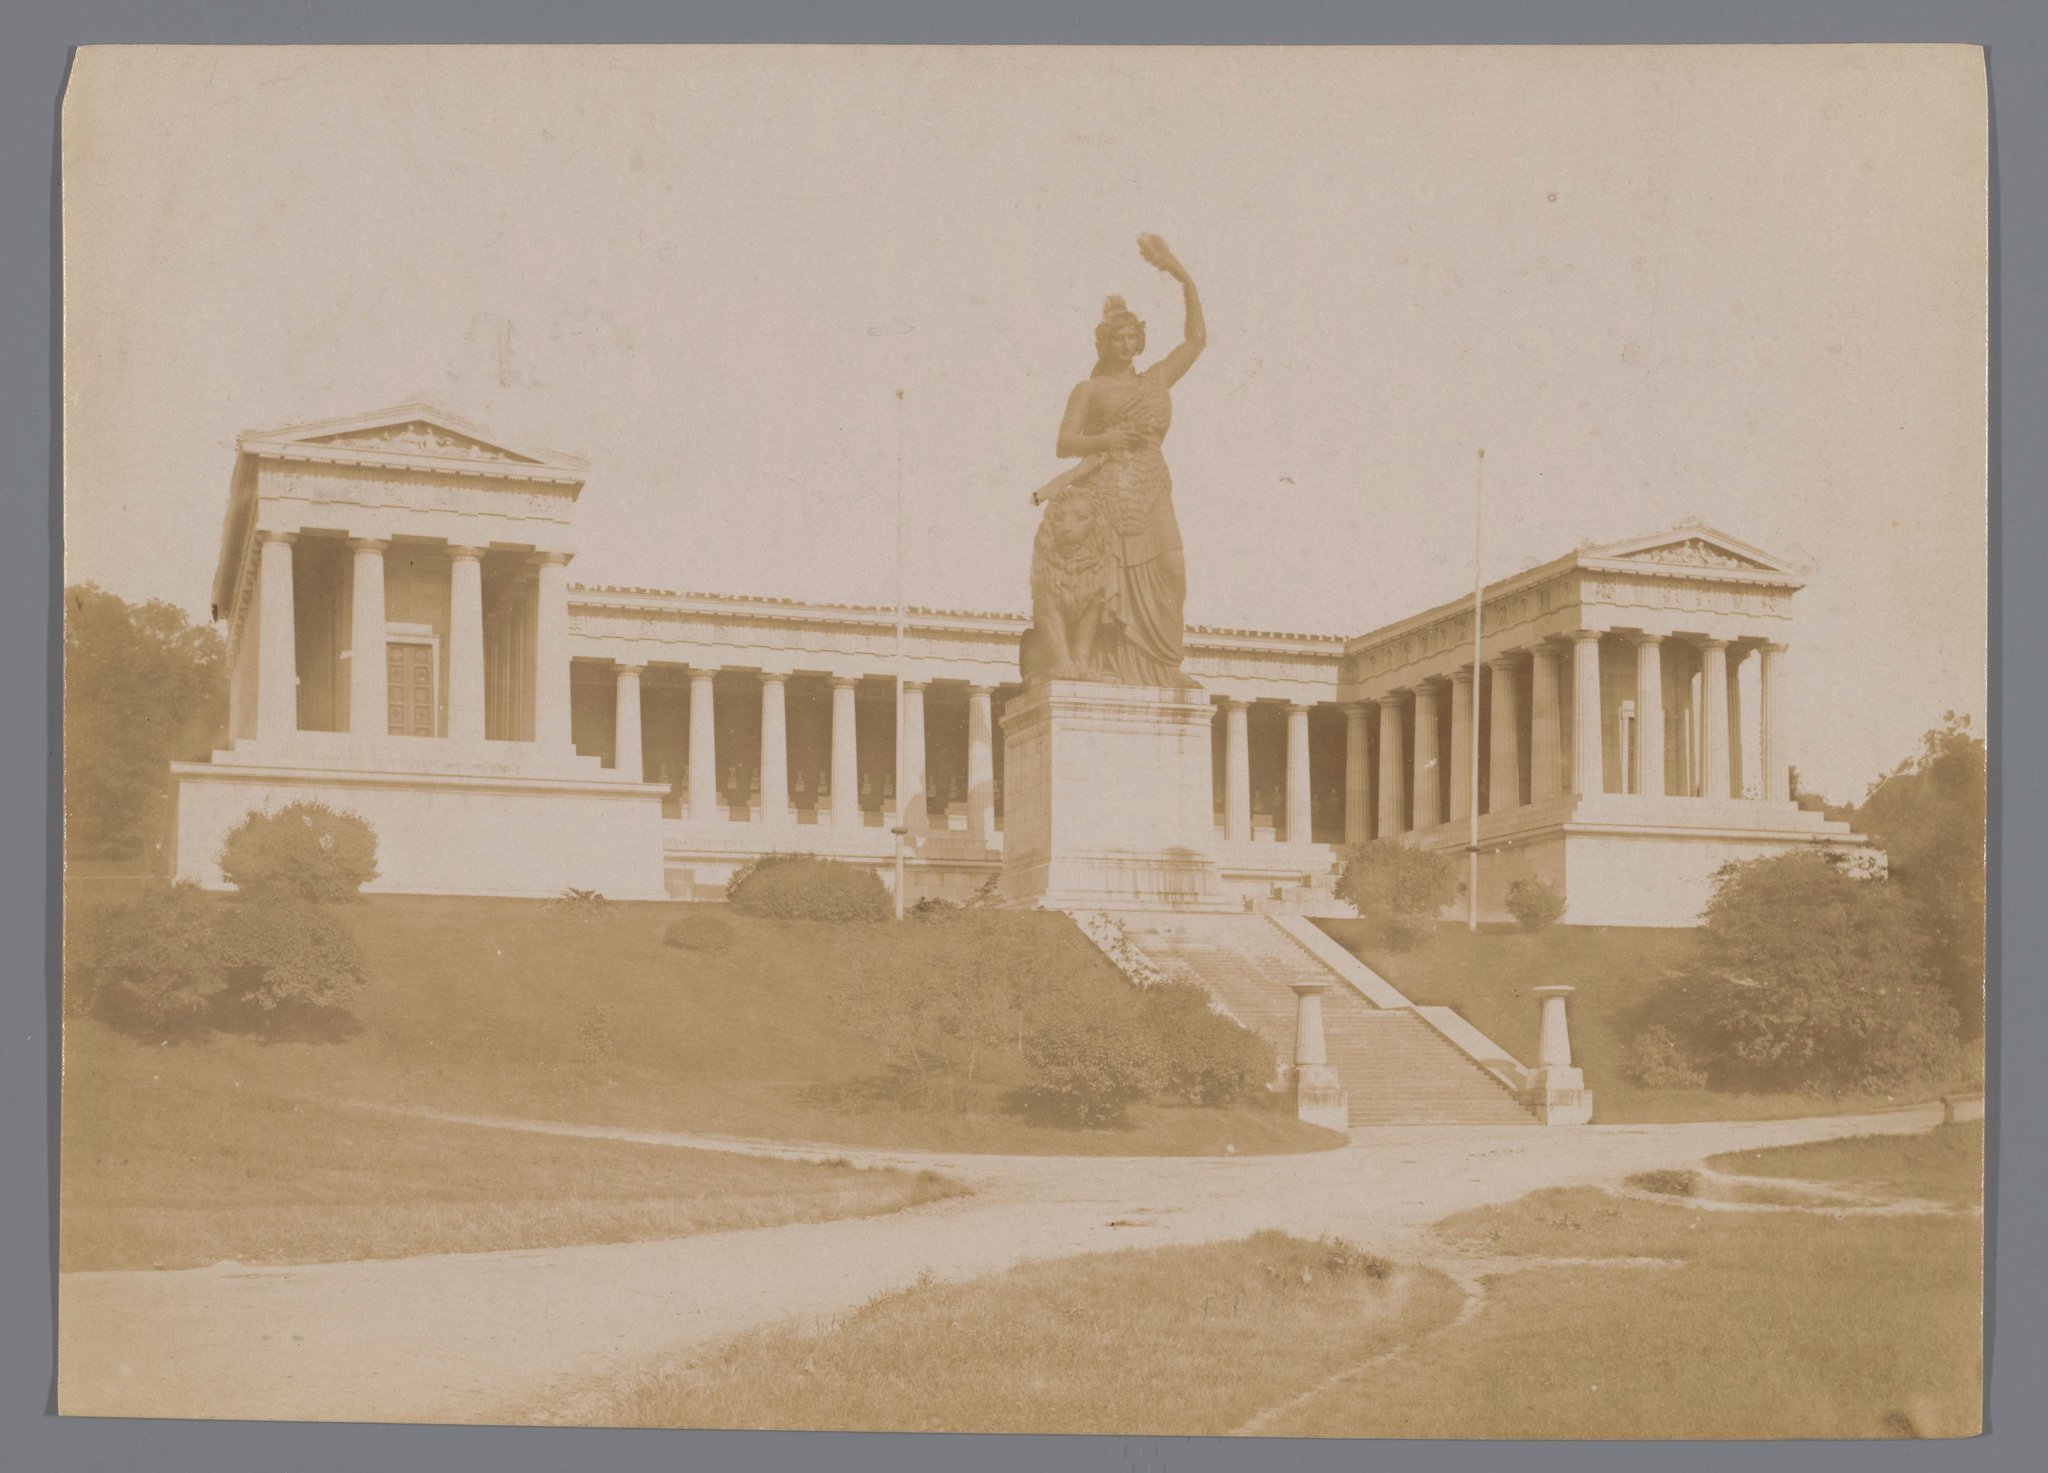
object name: photograph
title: Ruhmeshalle in München met standbeeld van Bavaria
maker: Anonymous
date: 1880-1900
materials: paper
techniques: albumen print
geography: munich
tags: monument, statue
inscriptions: inscription: ‘München/ Ruhmeshalle mit Bavaria’